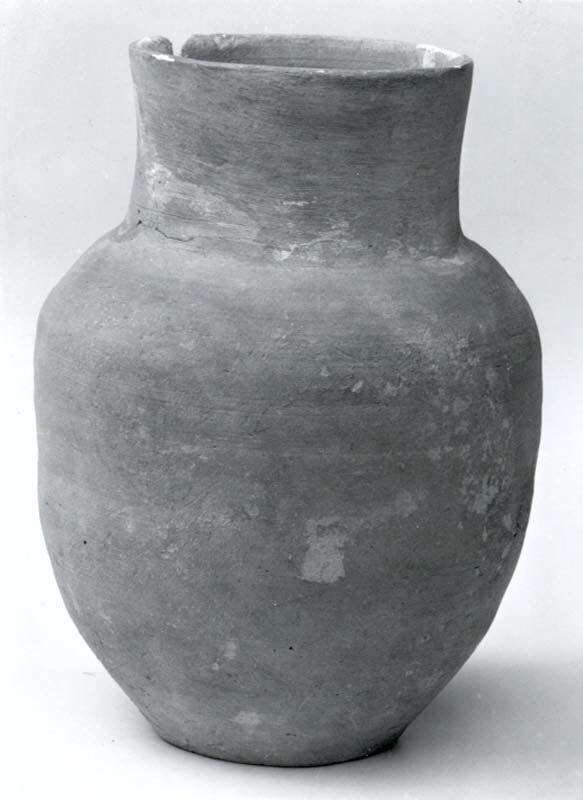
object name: jar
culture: sumerian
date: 2600-2350 BCE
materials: ceramic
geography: mesopotamia